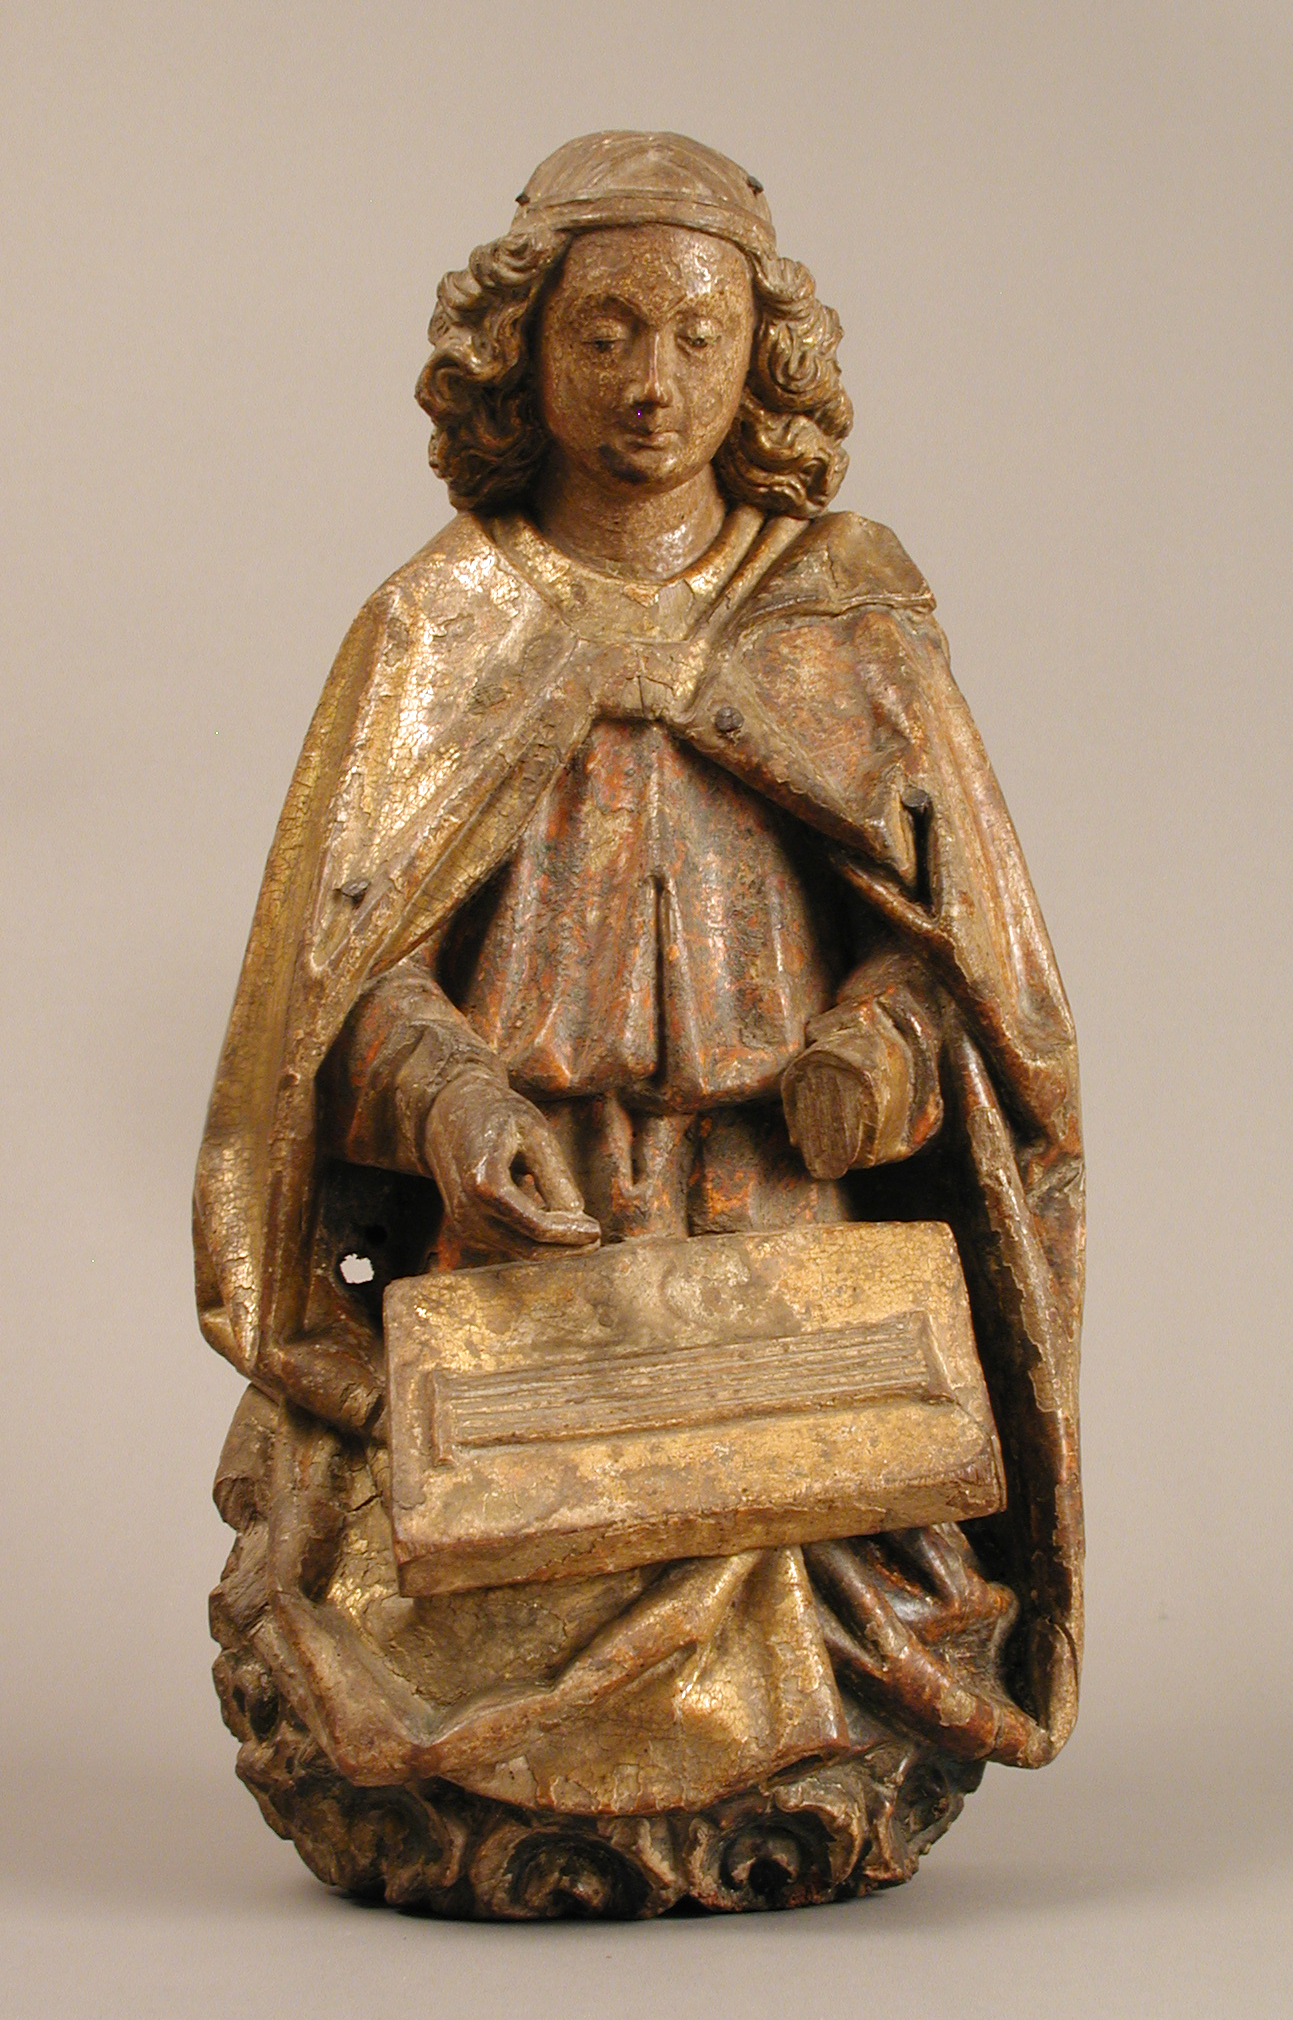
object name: statuette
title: Angel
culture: german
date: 1460-1480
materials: wood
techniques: gilding, painting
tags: musical instruments